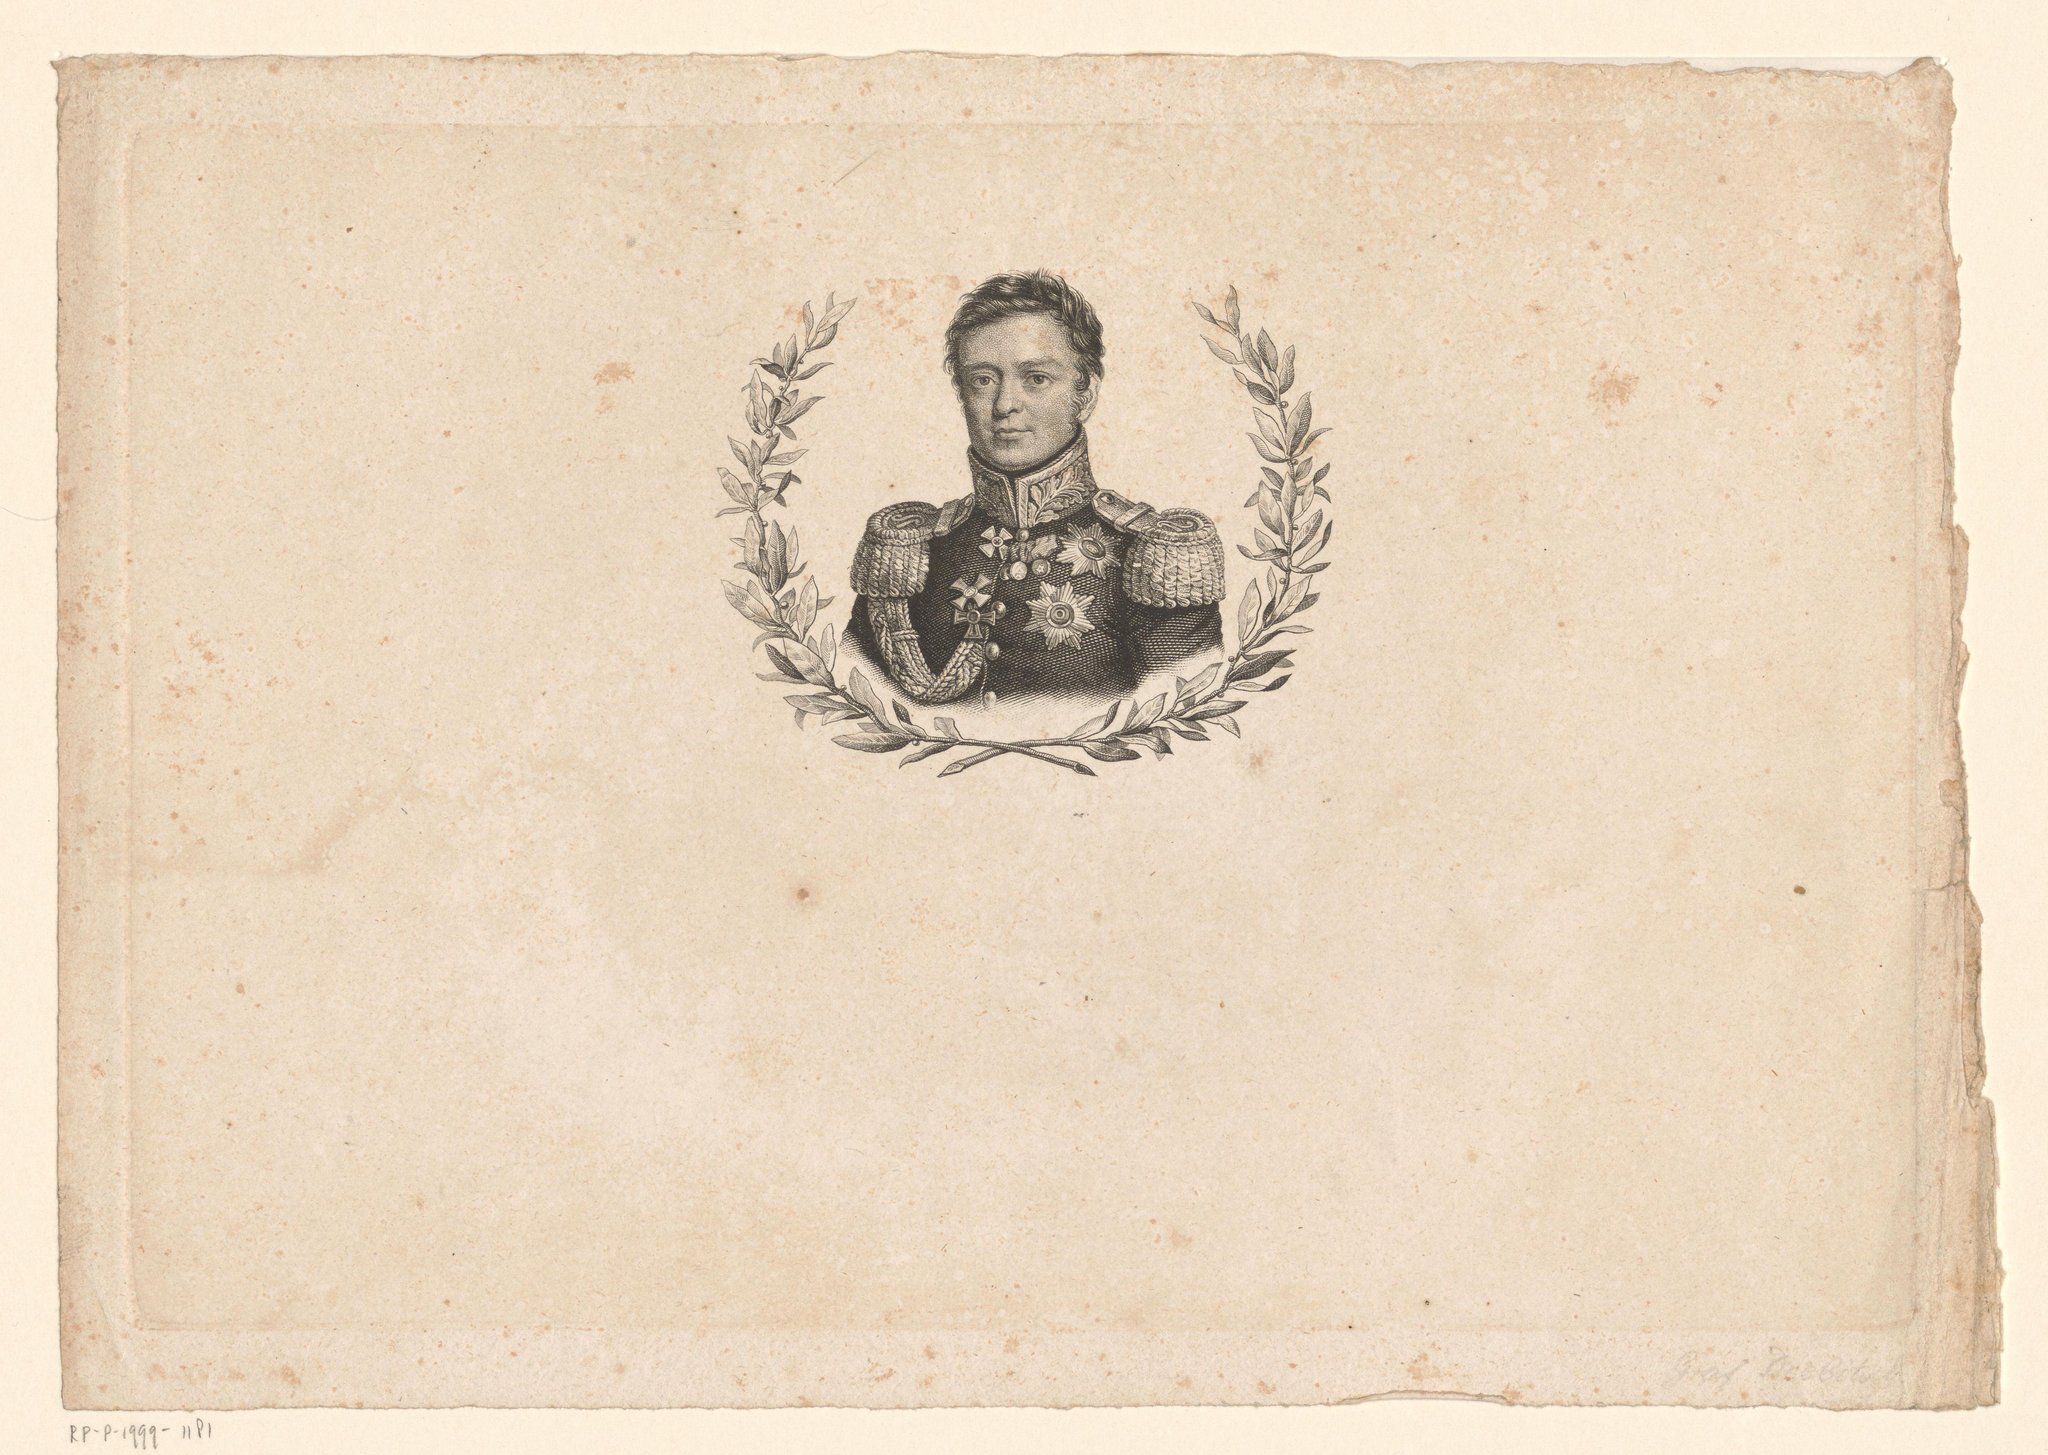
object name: print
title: Portret van Hans Karl von Diebitsch-Sabalkanski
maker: Anonymous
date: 1830-1850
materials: paper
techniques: engraving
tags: knighthood order (with name) - insignia of a knighthood order, e.g.: badge, chain (with name of order), commander-in-chief, general, marshal, historical persons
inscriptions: collector's mark: Lugt 2760, collector's mark: Lugt 2228